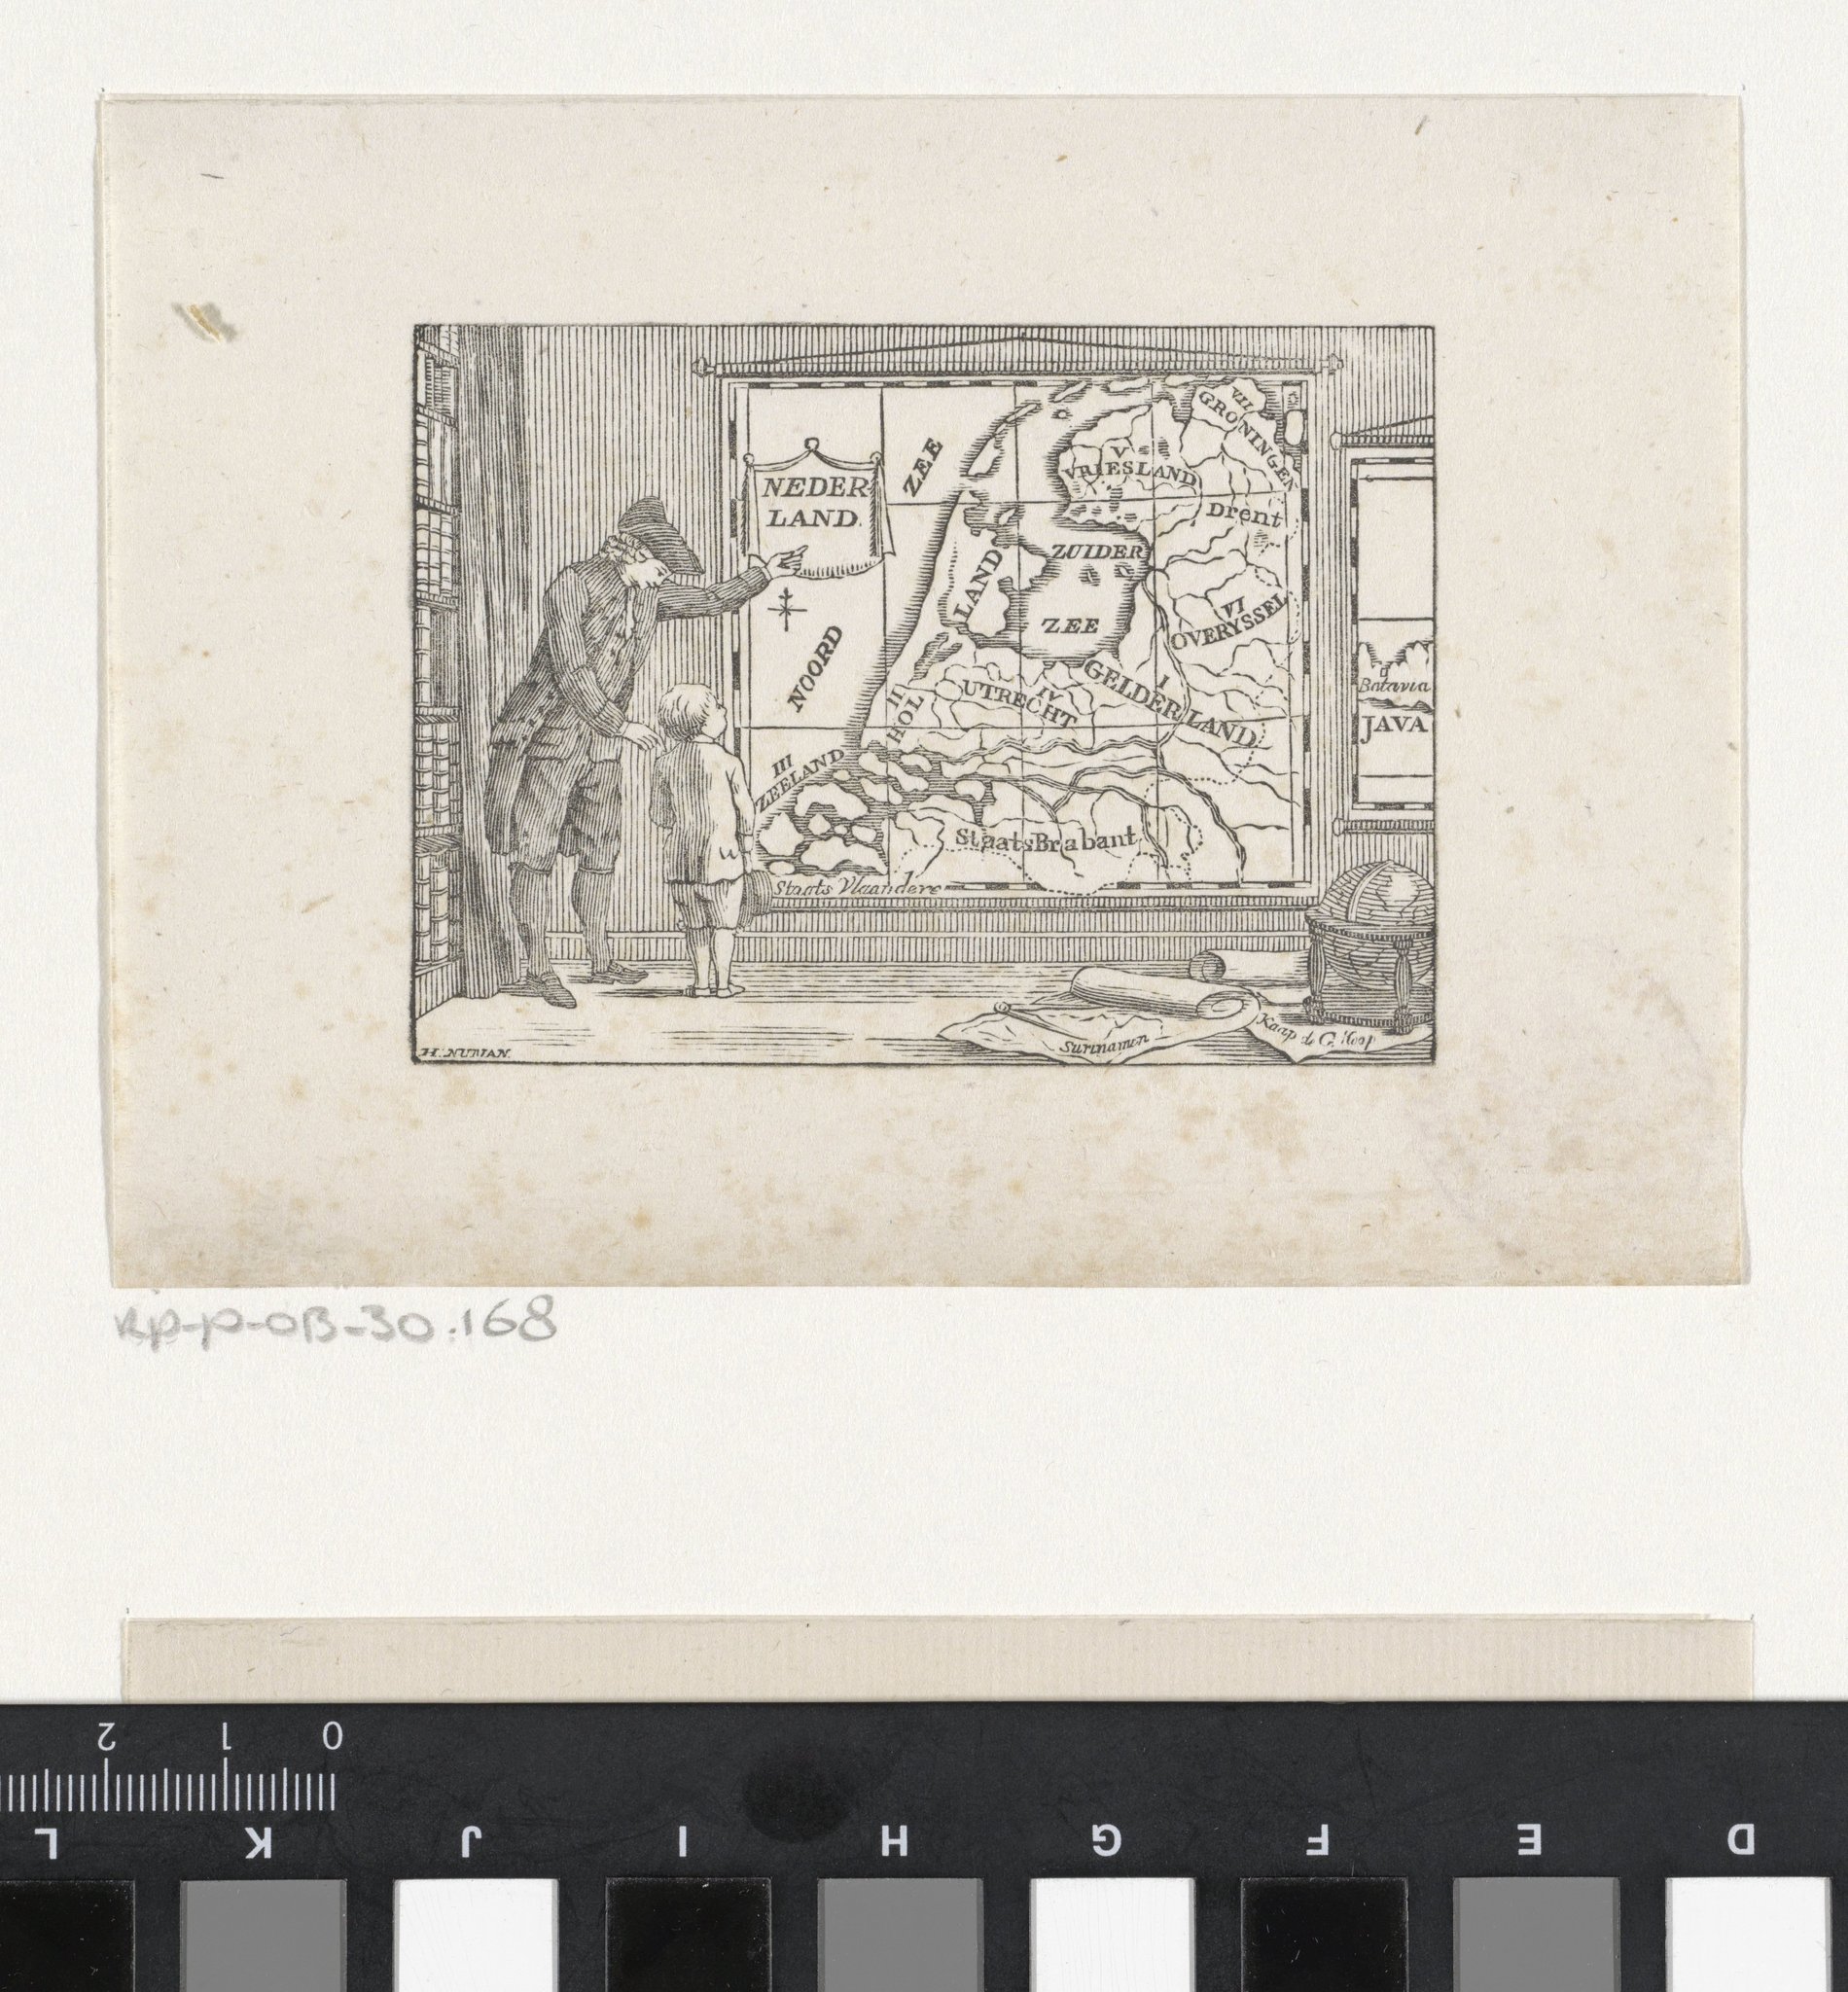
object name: print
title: Man leert een jongen over de topografie van Nederland op een wandkaart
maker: hendrik numan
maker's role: draughtsman, print maker, publisher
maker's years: 1736-1788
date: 1746-1788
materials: paper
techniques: woodcut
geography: haarlem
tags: boy (child between toddler and youth), maps, atlases, education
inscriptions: collector's mark: Lugt 240